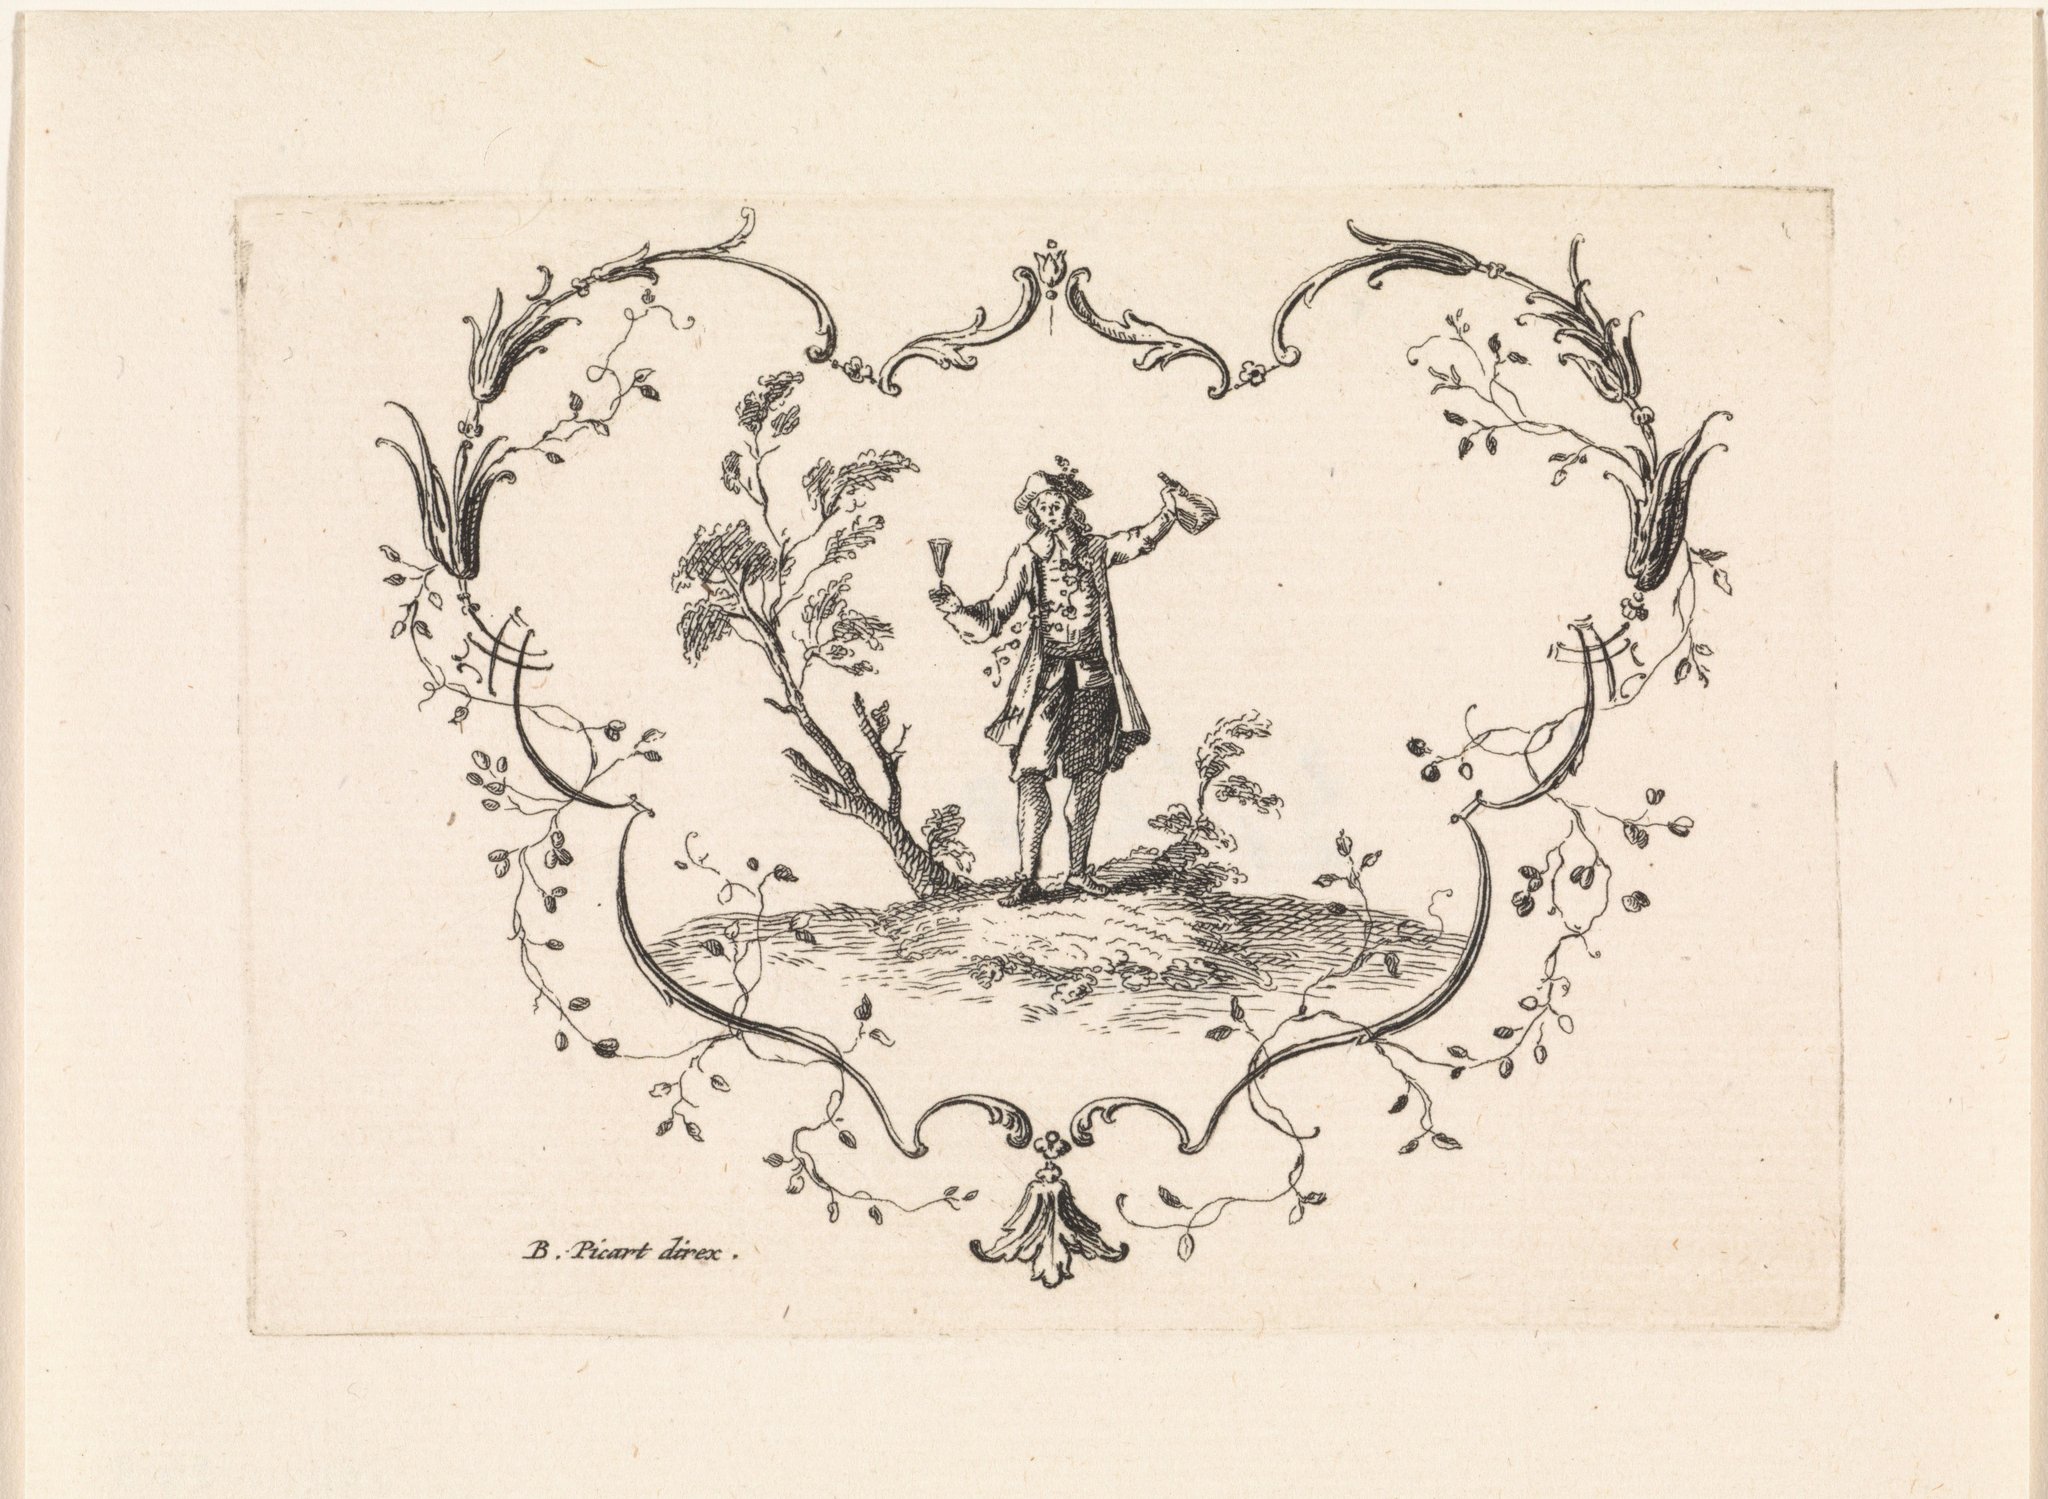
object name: print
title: Man met karaf en glas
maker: bernard picart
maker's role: draughtsman, print maker, publisher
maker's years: 1673-1733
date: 1683-1733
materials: paper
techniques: etching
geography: amsterdam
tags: glass, rummer, flowers ~ ornament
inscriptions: collector's mark: Lugt 2233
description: Een man met karaf in de ene hand en glas in de andere hand in de buitenlucht. Rondom de voorstelling bladranken.